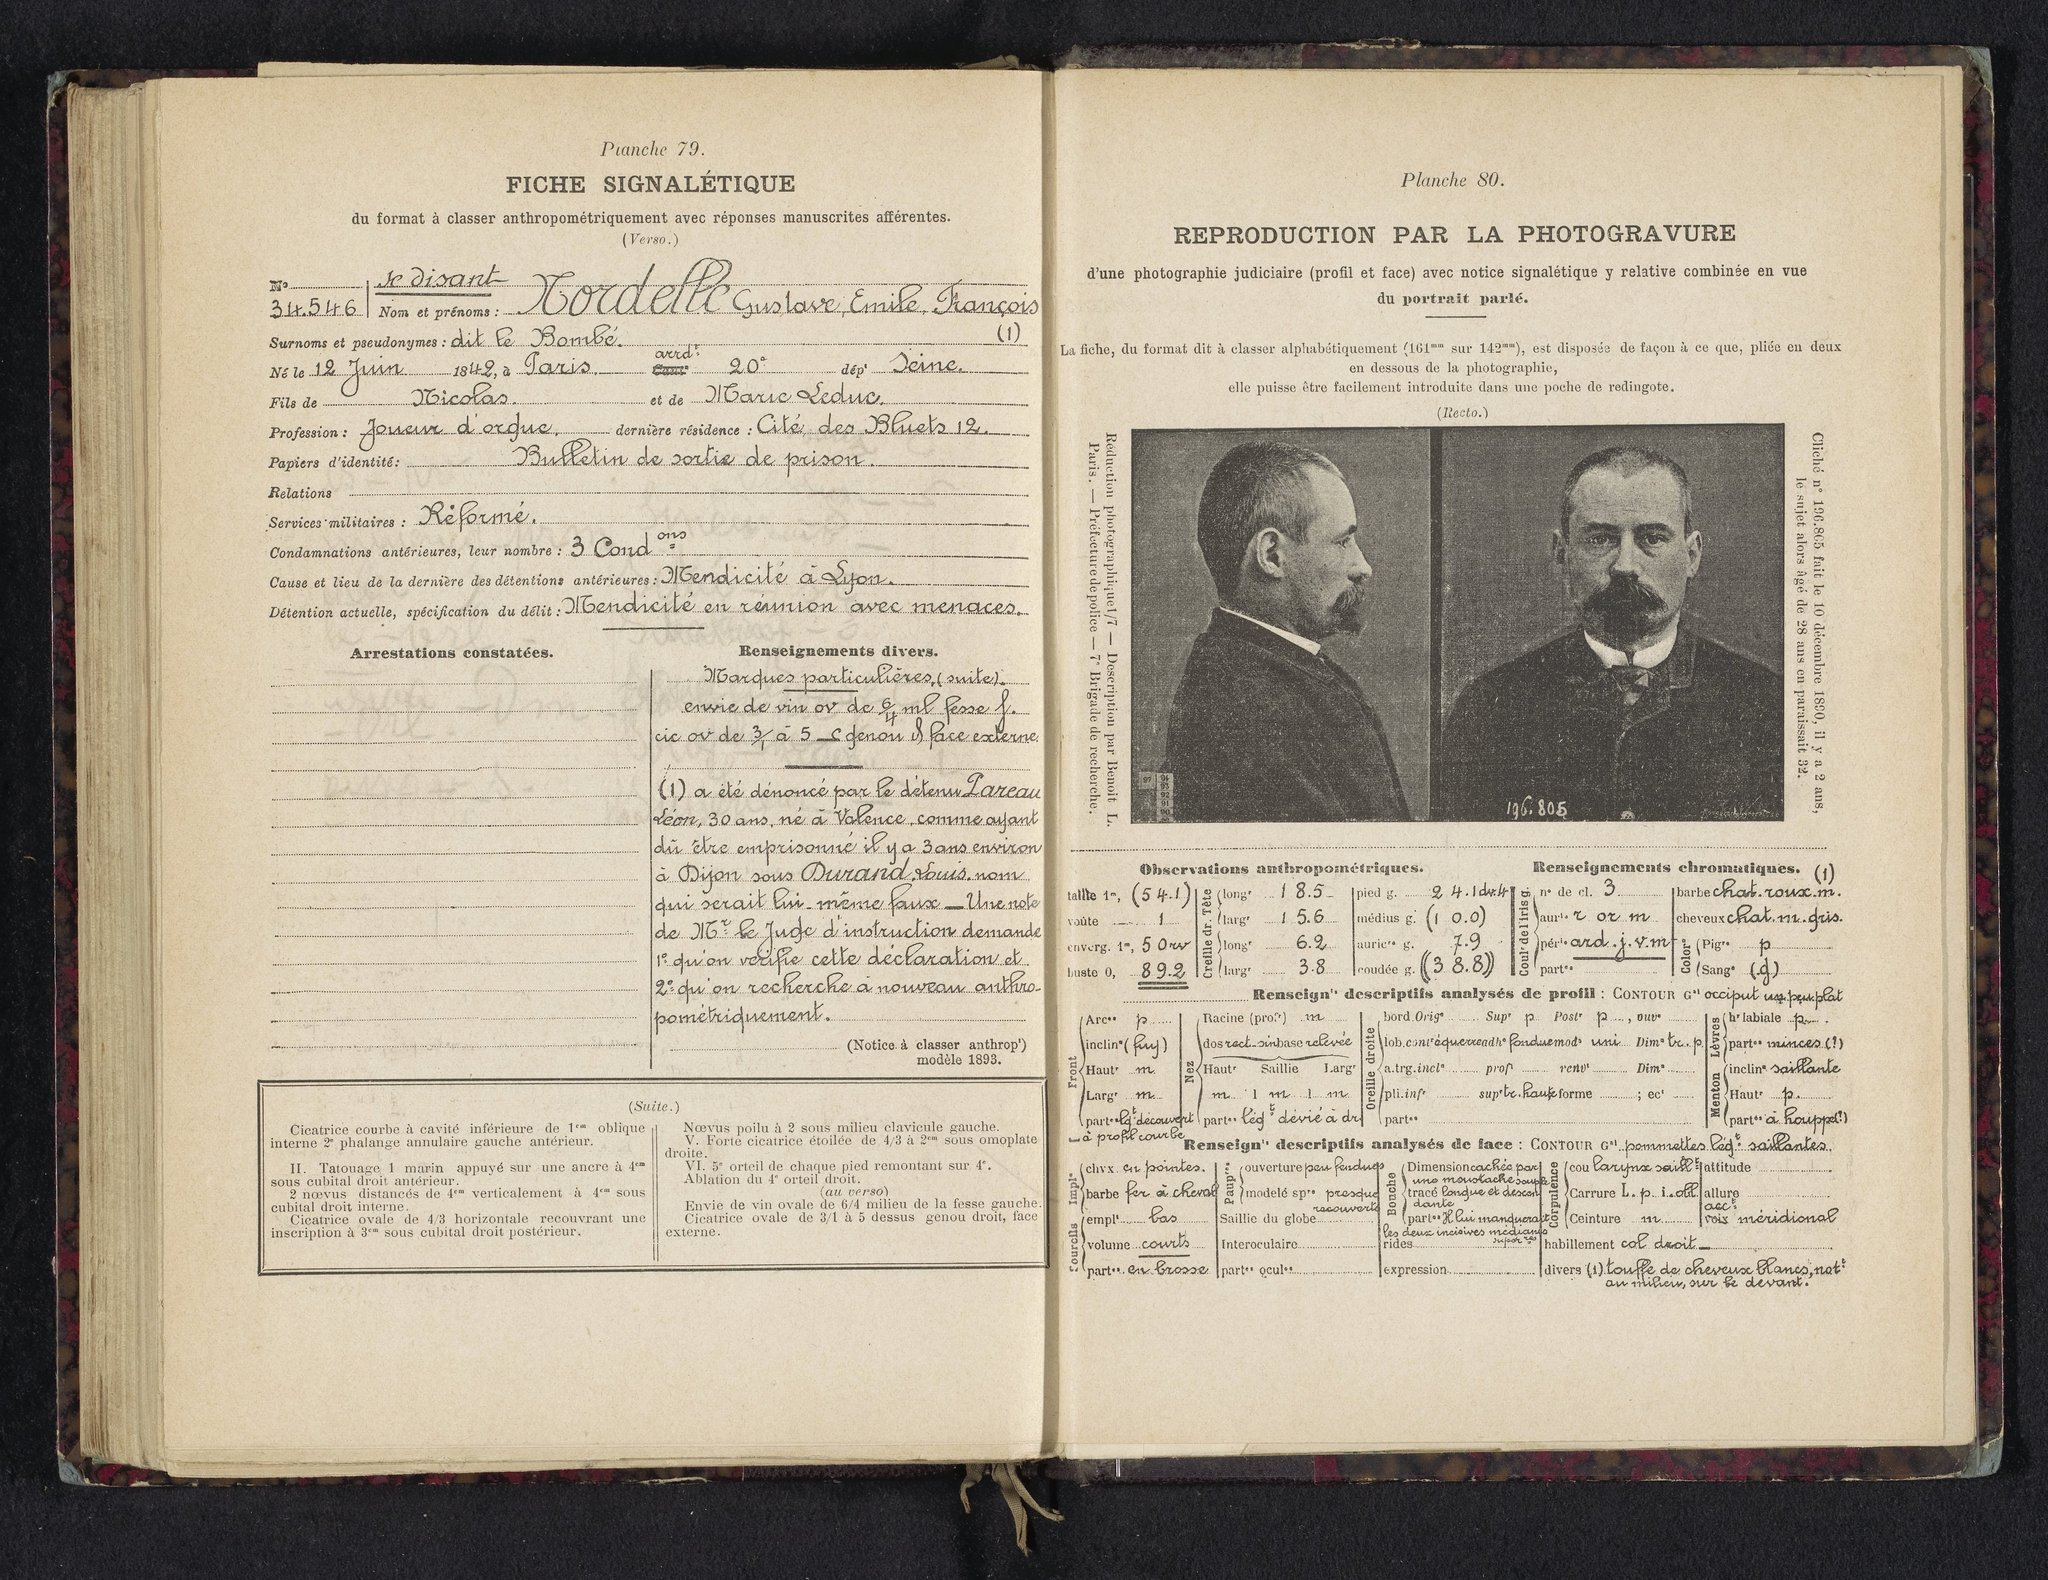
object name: page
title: Man met een snor, in vooraanzicht en zijaanzicht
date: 1890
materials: paper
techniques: photochemical processes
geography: france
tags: head (human) (+ front view), head (human) (+ sideview, profile), france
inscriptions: number: ‘Planche 80.’, number: ‘196.805’, inscription: ‘La fiche, du format dit à classer alphabetiquement (161mm sur 142mm), est disposée de facon à en ce que, pliée en deux en dessous de la photographie, elle puisse être facilement introduite dans une poche de redingote.’, inscription: ‘Cliché no 193.805 fait le 10 décembre 1890, il y a 2 ans, le sujet alors âgé de 28 ans en paraissait 32. Réduction photographique 1/7 - Description par Benoit L. Paris. - Préfecture de police - 7e Brigade de recherche.’